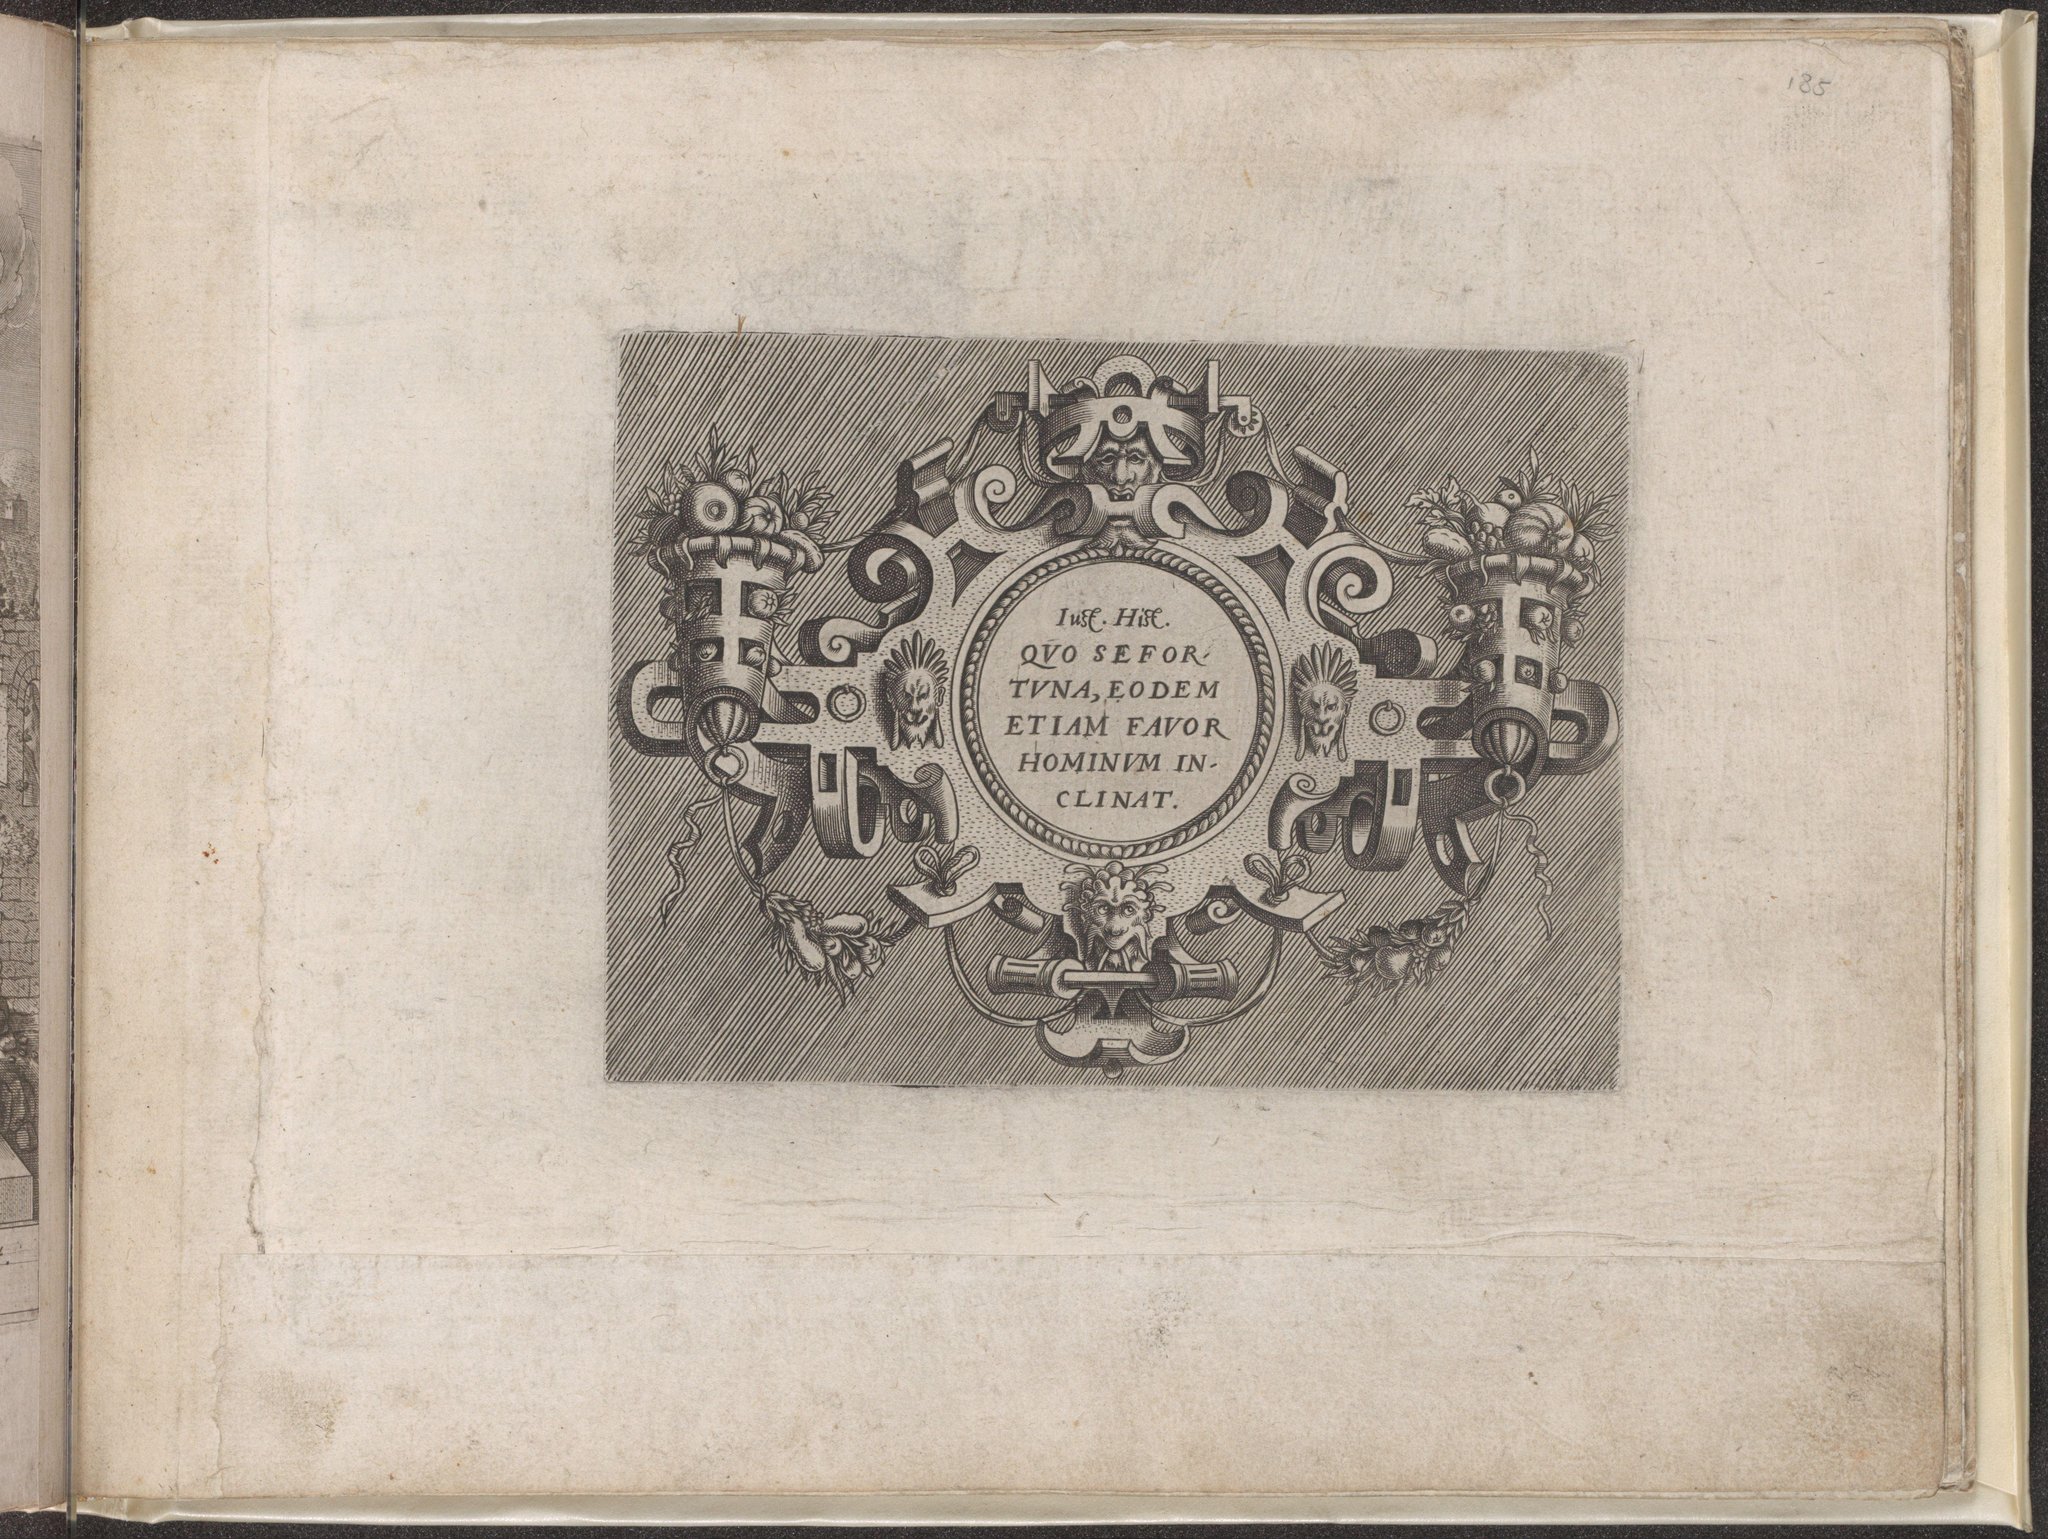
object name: print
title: Variarum Protractionum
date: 1557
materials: paper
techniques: engraving, etching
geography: antwerp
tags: scrollwork, strapwork ~ ornament, ornament ~ cartouche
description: Cartouche met een tekst in het Latijn. Links en rechts vazen met vruchten in het randwerk. Deze prent maakt deel uit van een album.